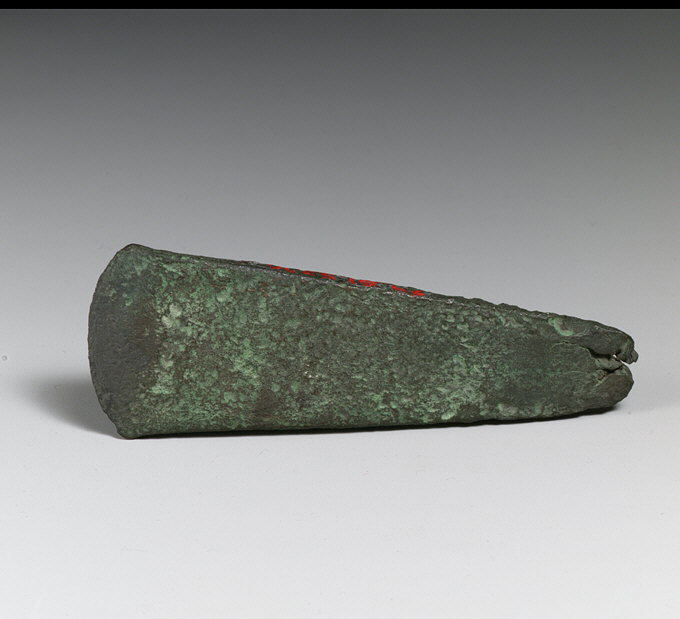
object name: axehead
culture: cypriot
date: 3200-2000 BCE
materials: bronze